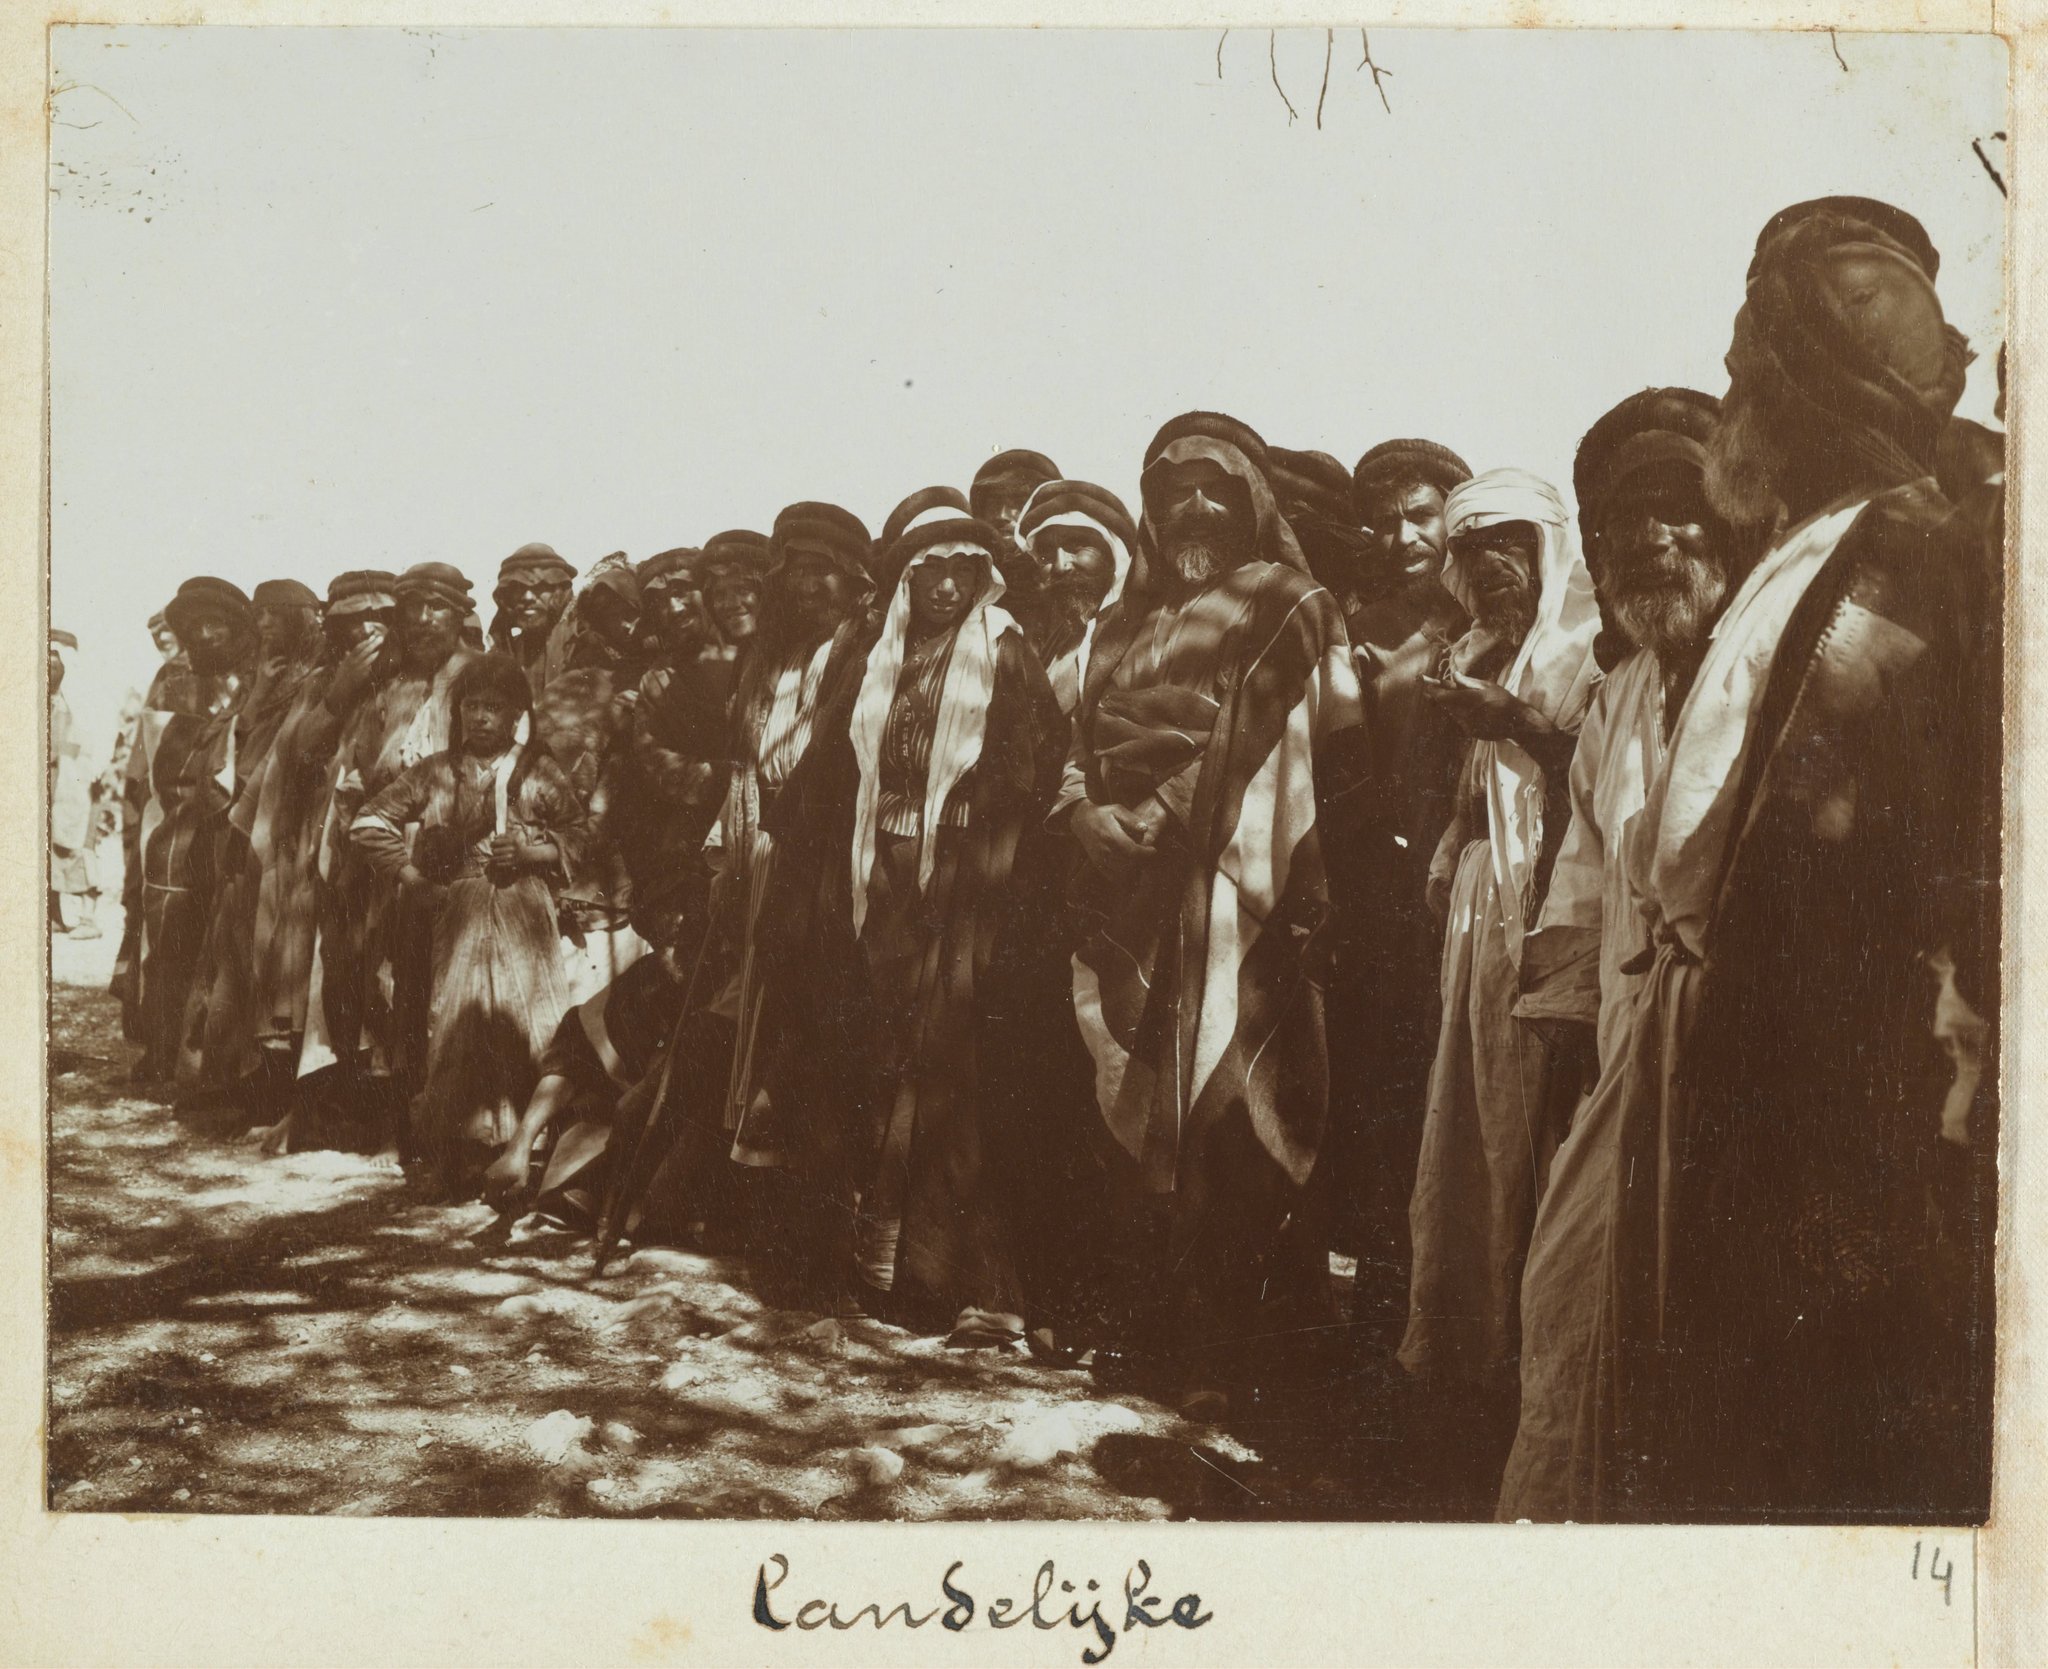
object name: page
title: Inwoners van Umm Qais, Jordanië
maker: johannes lodewijk heldring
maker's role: fotograaf, predikant, schrijver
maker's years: 1852-1923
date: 1898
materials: paper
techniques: collodion silver print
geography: jordan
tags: anonymous historical persons portrayed in a group, in a group-portrait